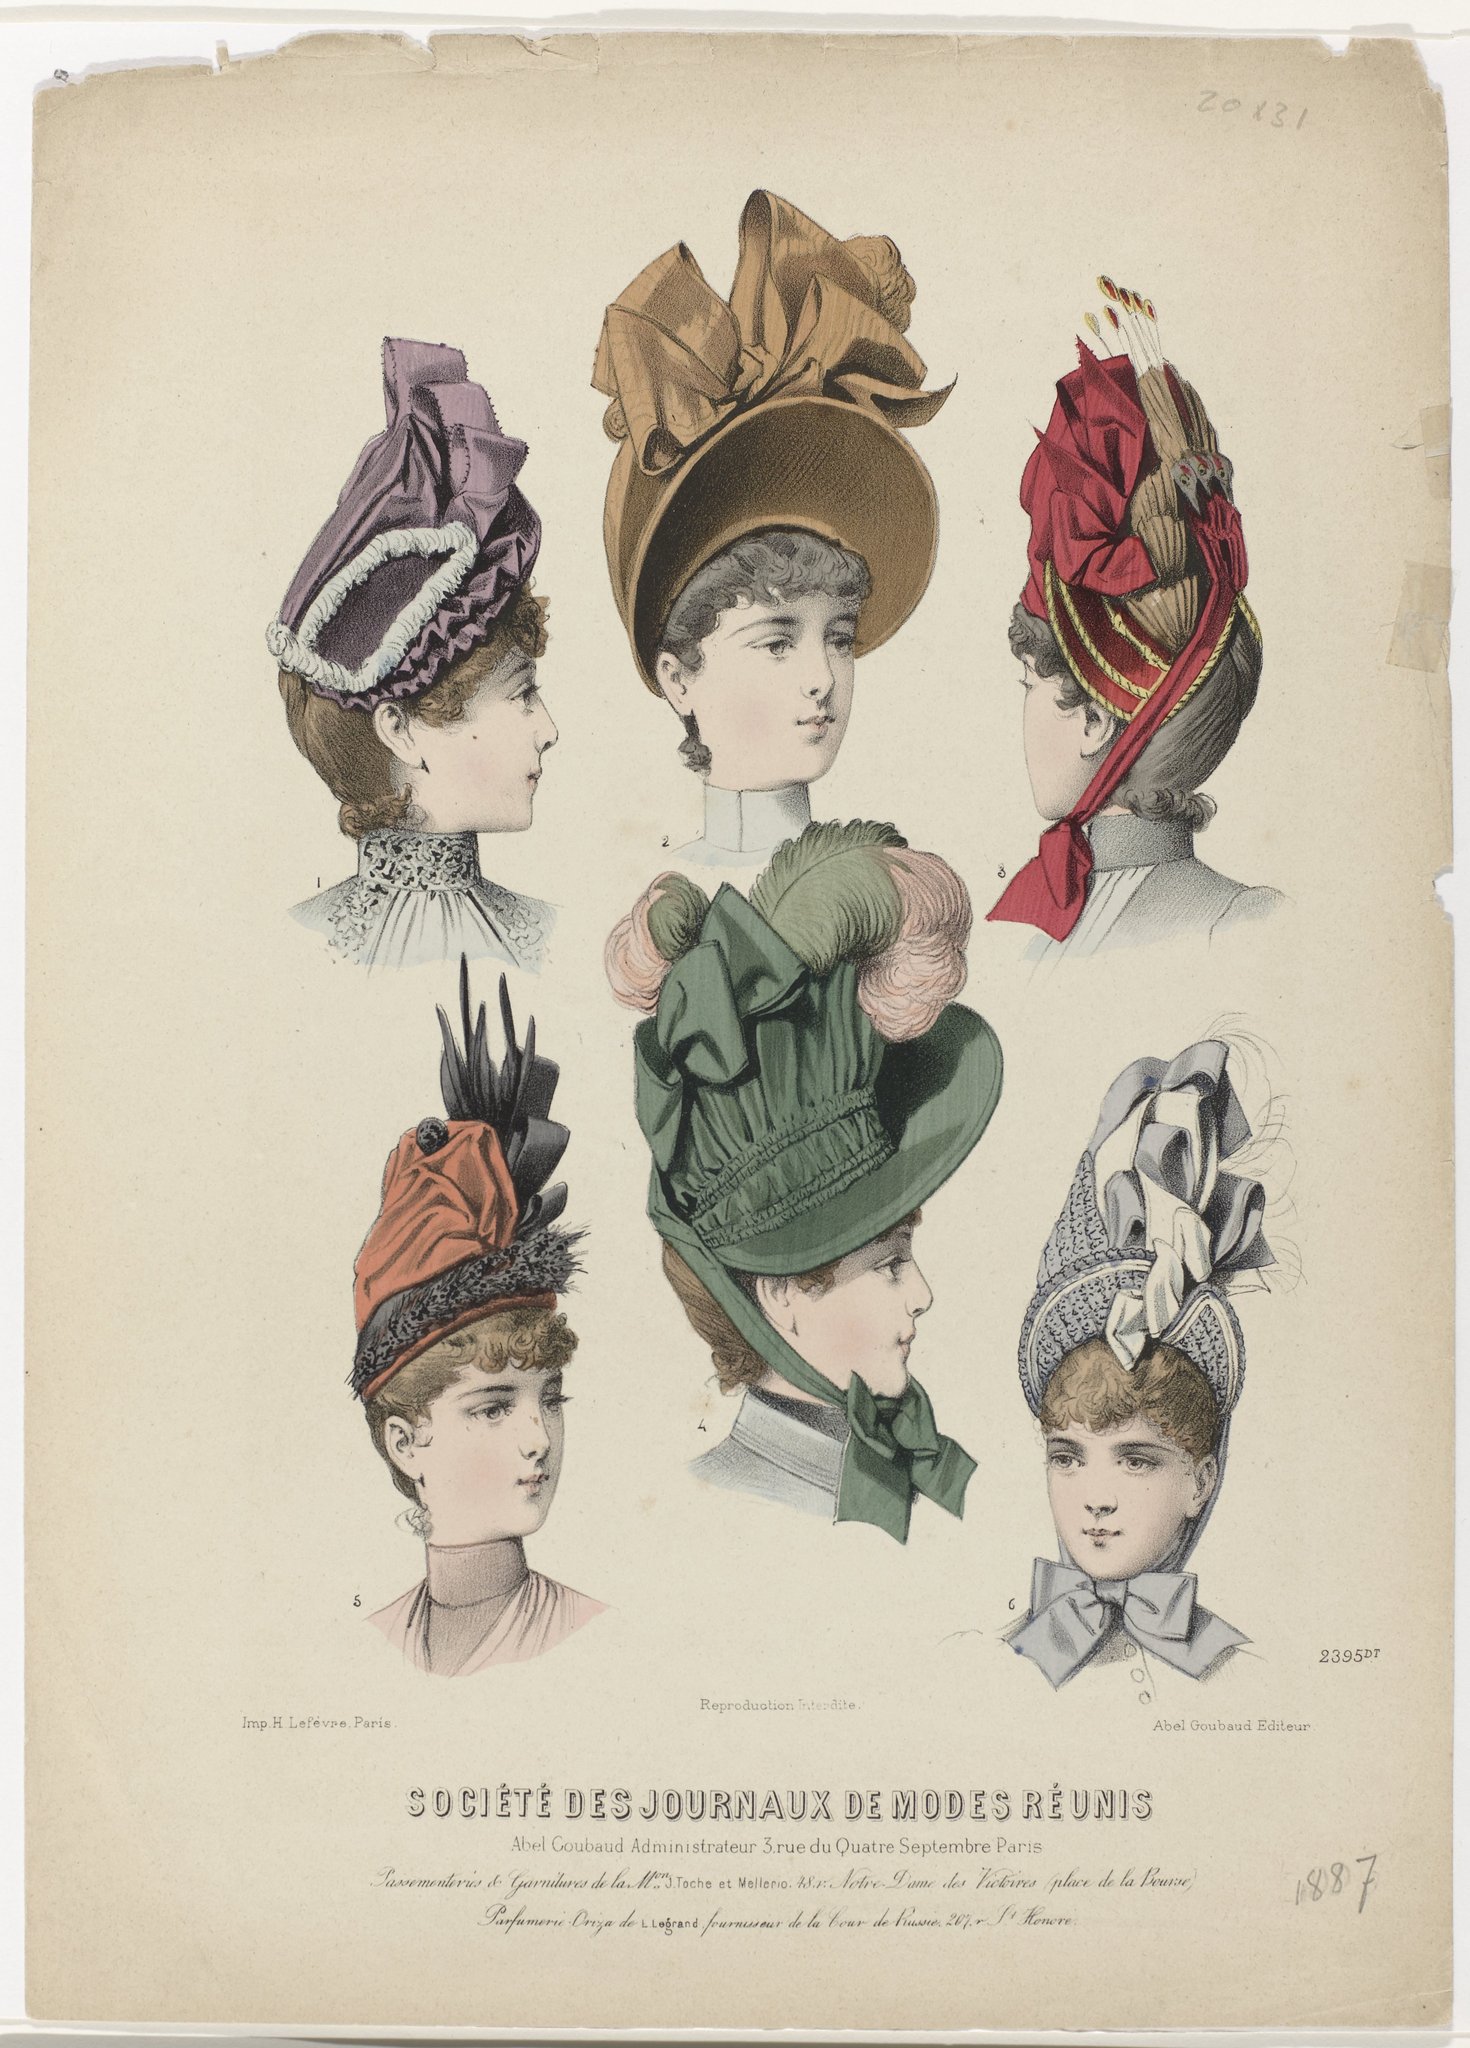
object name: fashion print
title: Société des journaux de modes Réunis, 1887, Nr. 2395 DT : Passementeries et Garnitures (...)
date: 1887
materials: paper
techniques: hand coloring, lithograph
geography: paris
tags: fashion plates, head-gear: hat (+ women's clothes), head-gear: hat (+ feathers used for clothes)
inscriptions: title: ‘SOCIÉTÉ DES JOURNEUX DE MODES RÉUNIS’, address: ‘Abel Goubaud Administrateur 3, rue du Quatre Septembre Paris’, caption: ‘Passementeries & Garnitures de la M.on J. toche et Mellerio,48,r, Notre-Dame des Victoires (place de la Bourse) Parfumerie-Oriza de L.Legrand, fournisseur de la Cour de Russie, 207,r St Honoré.’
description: Zes vrouwenhoofden met verschillende hoeden, genummerd 1 tot en met 6. Onder de voorstelling enkele regels reclametekst voor verschillende producten. Prent uit het modetijdschrift Société des journaux de modes réunis (1847 -...?).